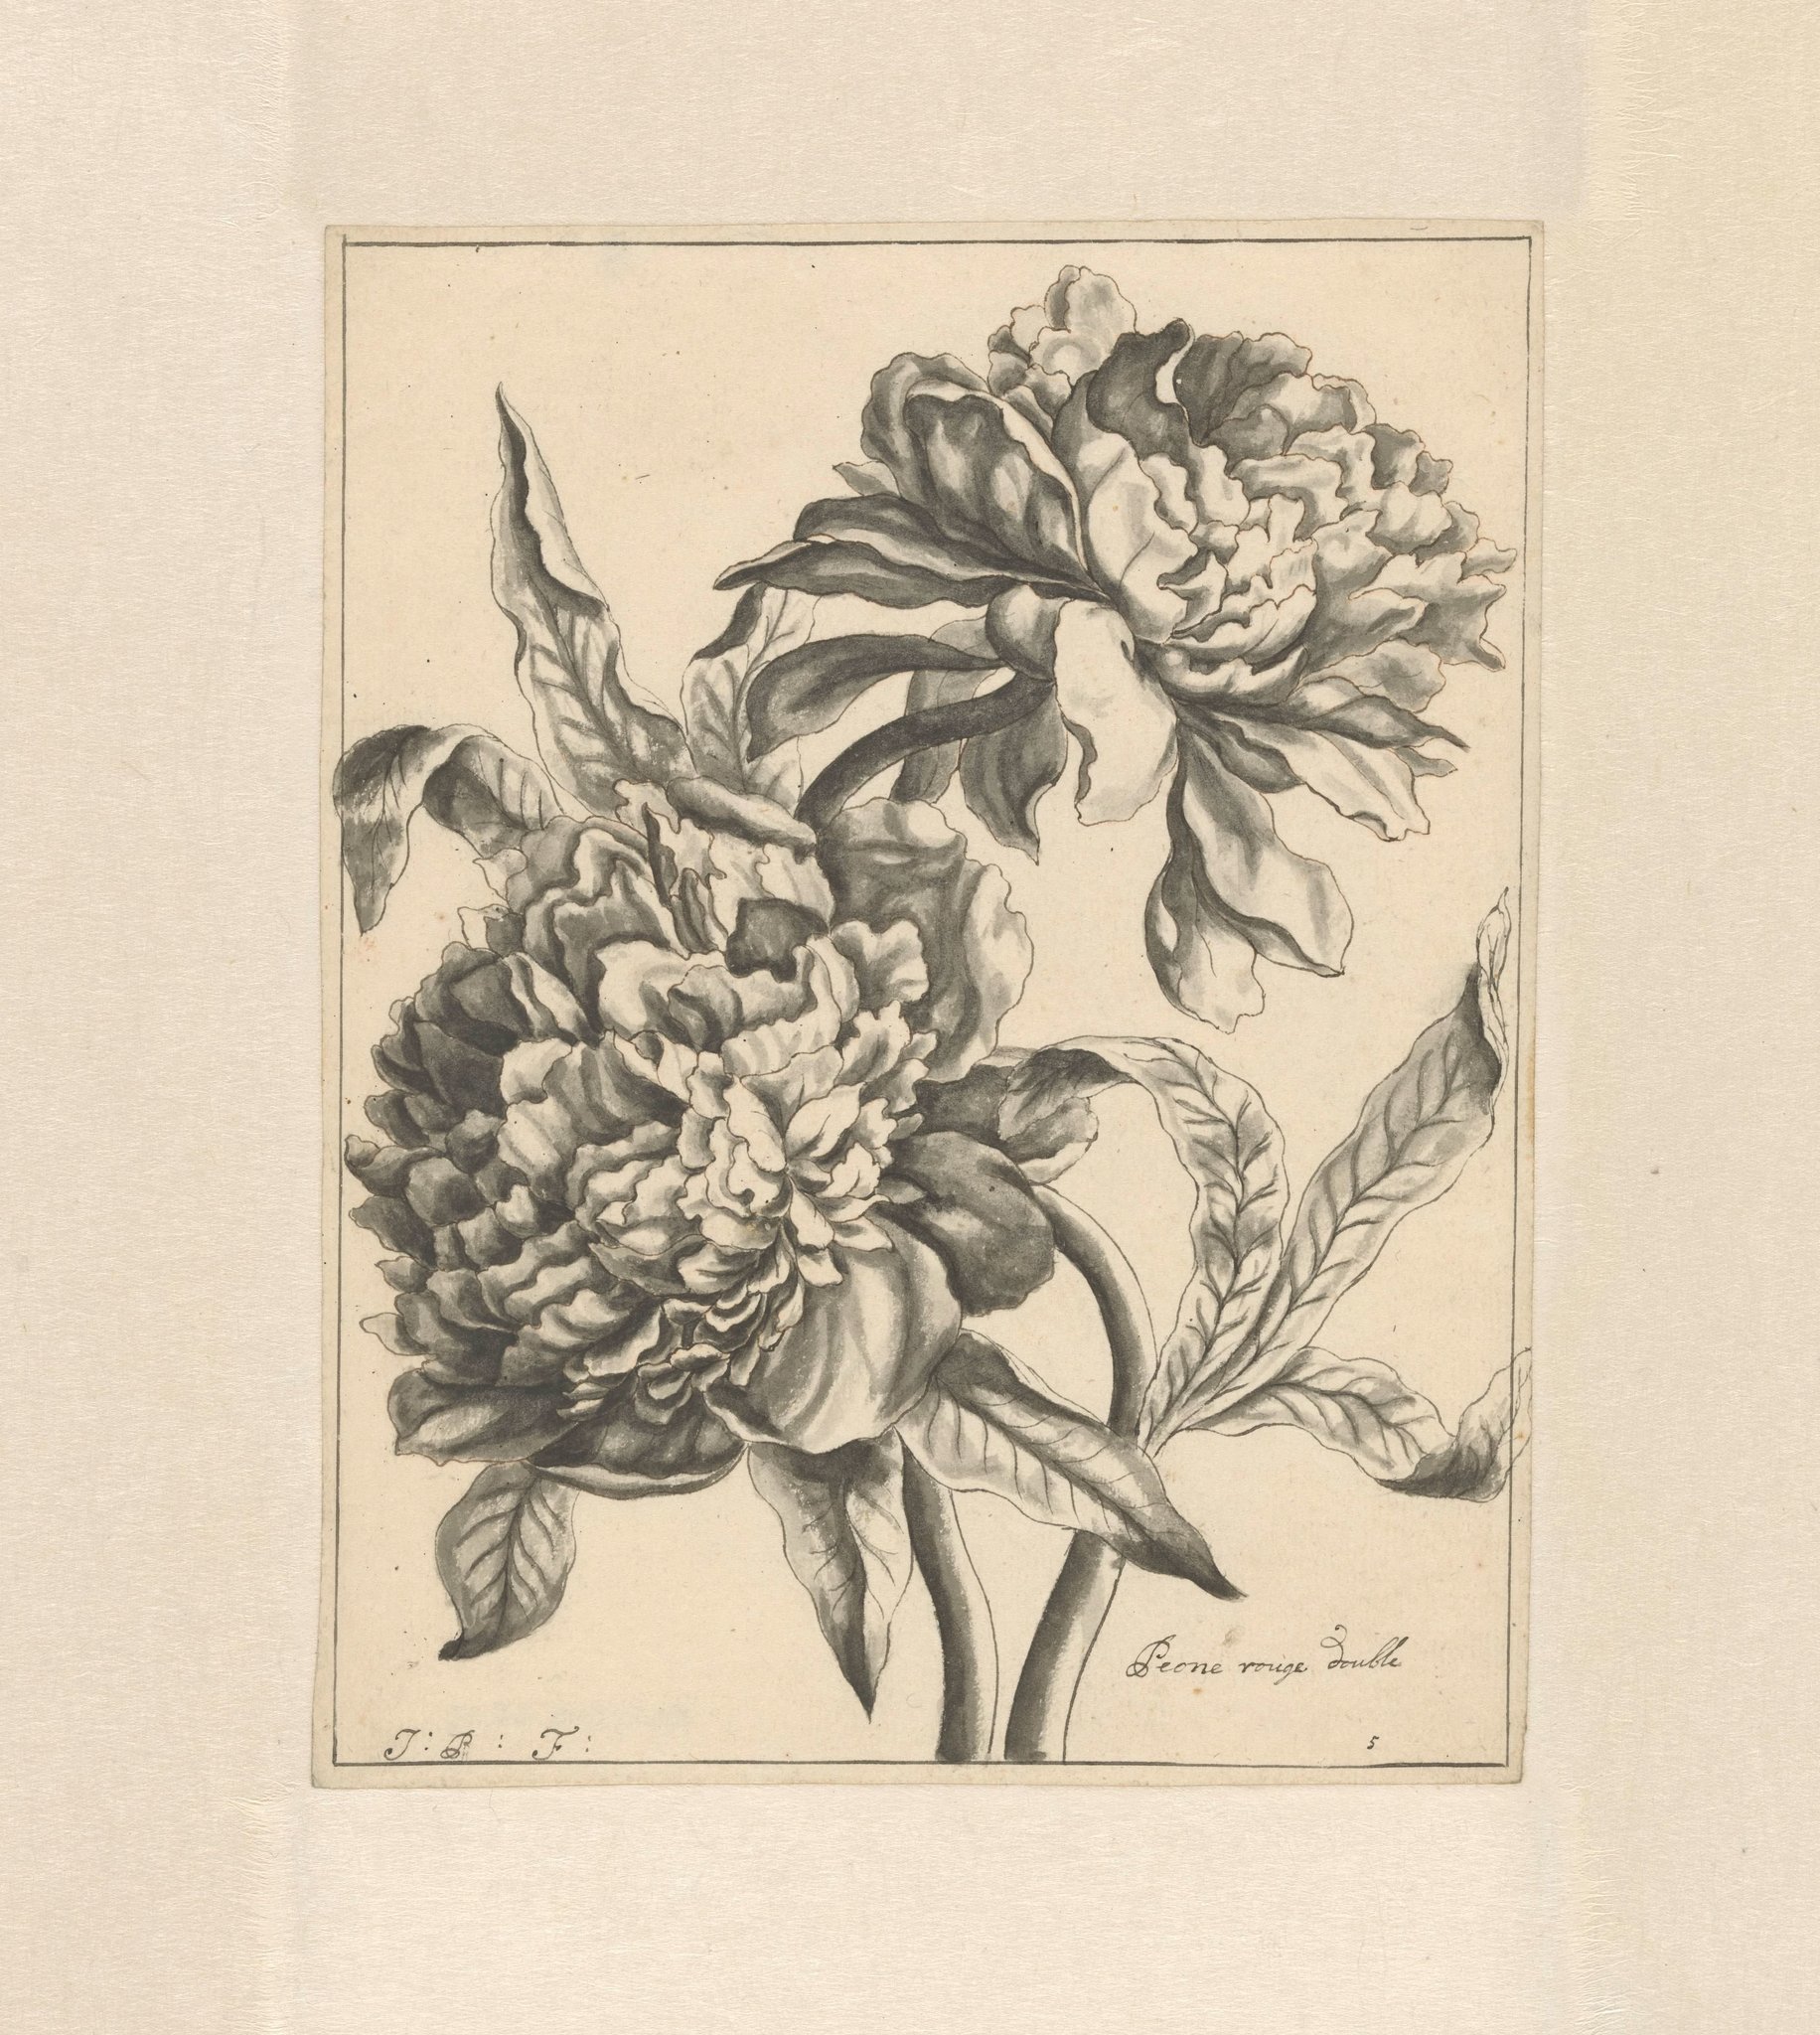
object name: drawing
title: Peone rouge double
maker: j. porteret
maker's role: draughtsman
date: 1700-1800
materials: paper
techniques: brush, pen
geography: france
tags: flowers: peony